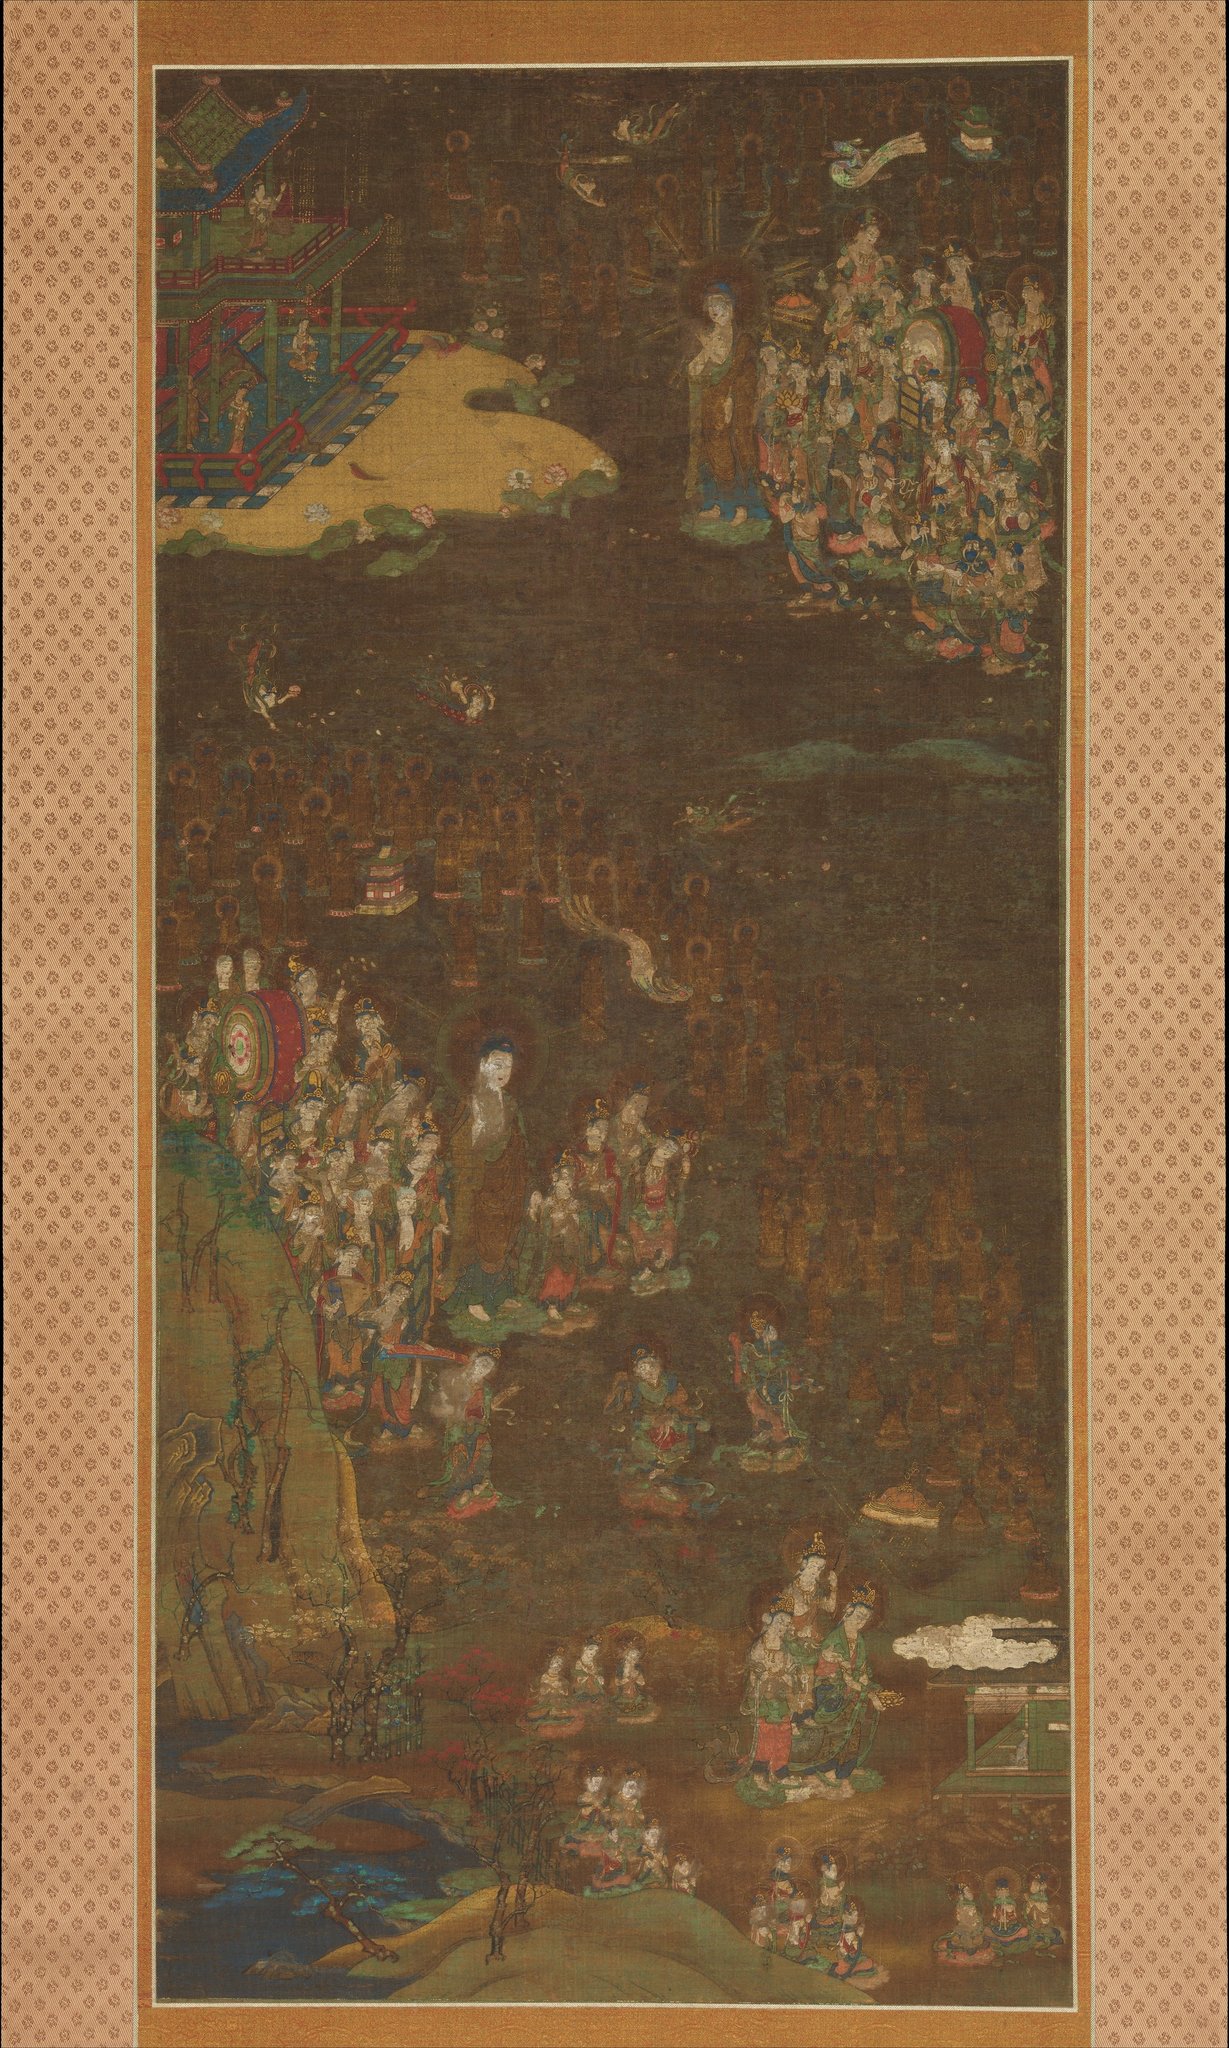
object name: hanging scroll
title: Descent and Return of Amida to Western Paradise with a Believer's Soul (Gōshō mandara)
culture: japanese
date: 1300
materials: ink, silk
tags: landscapes,buddha